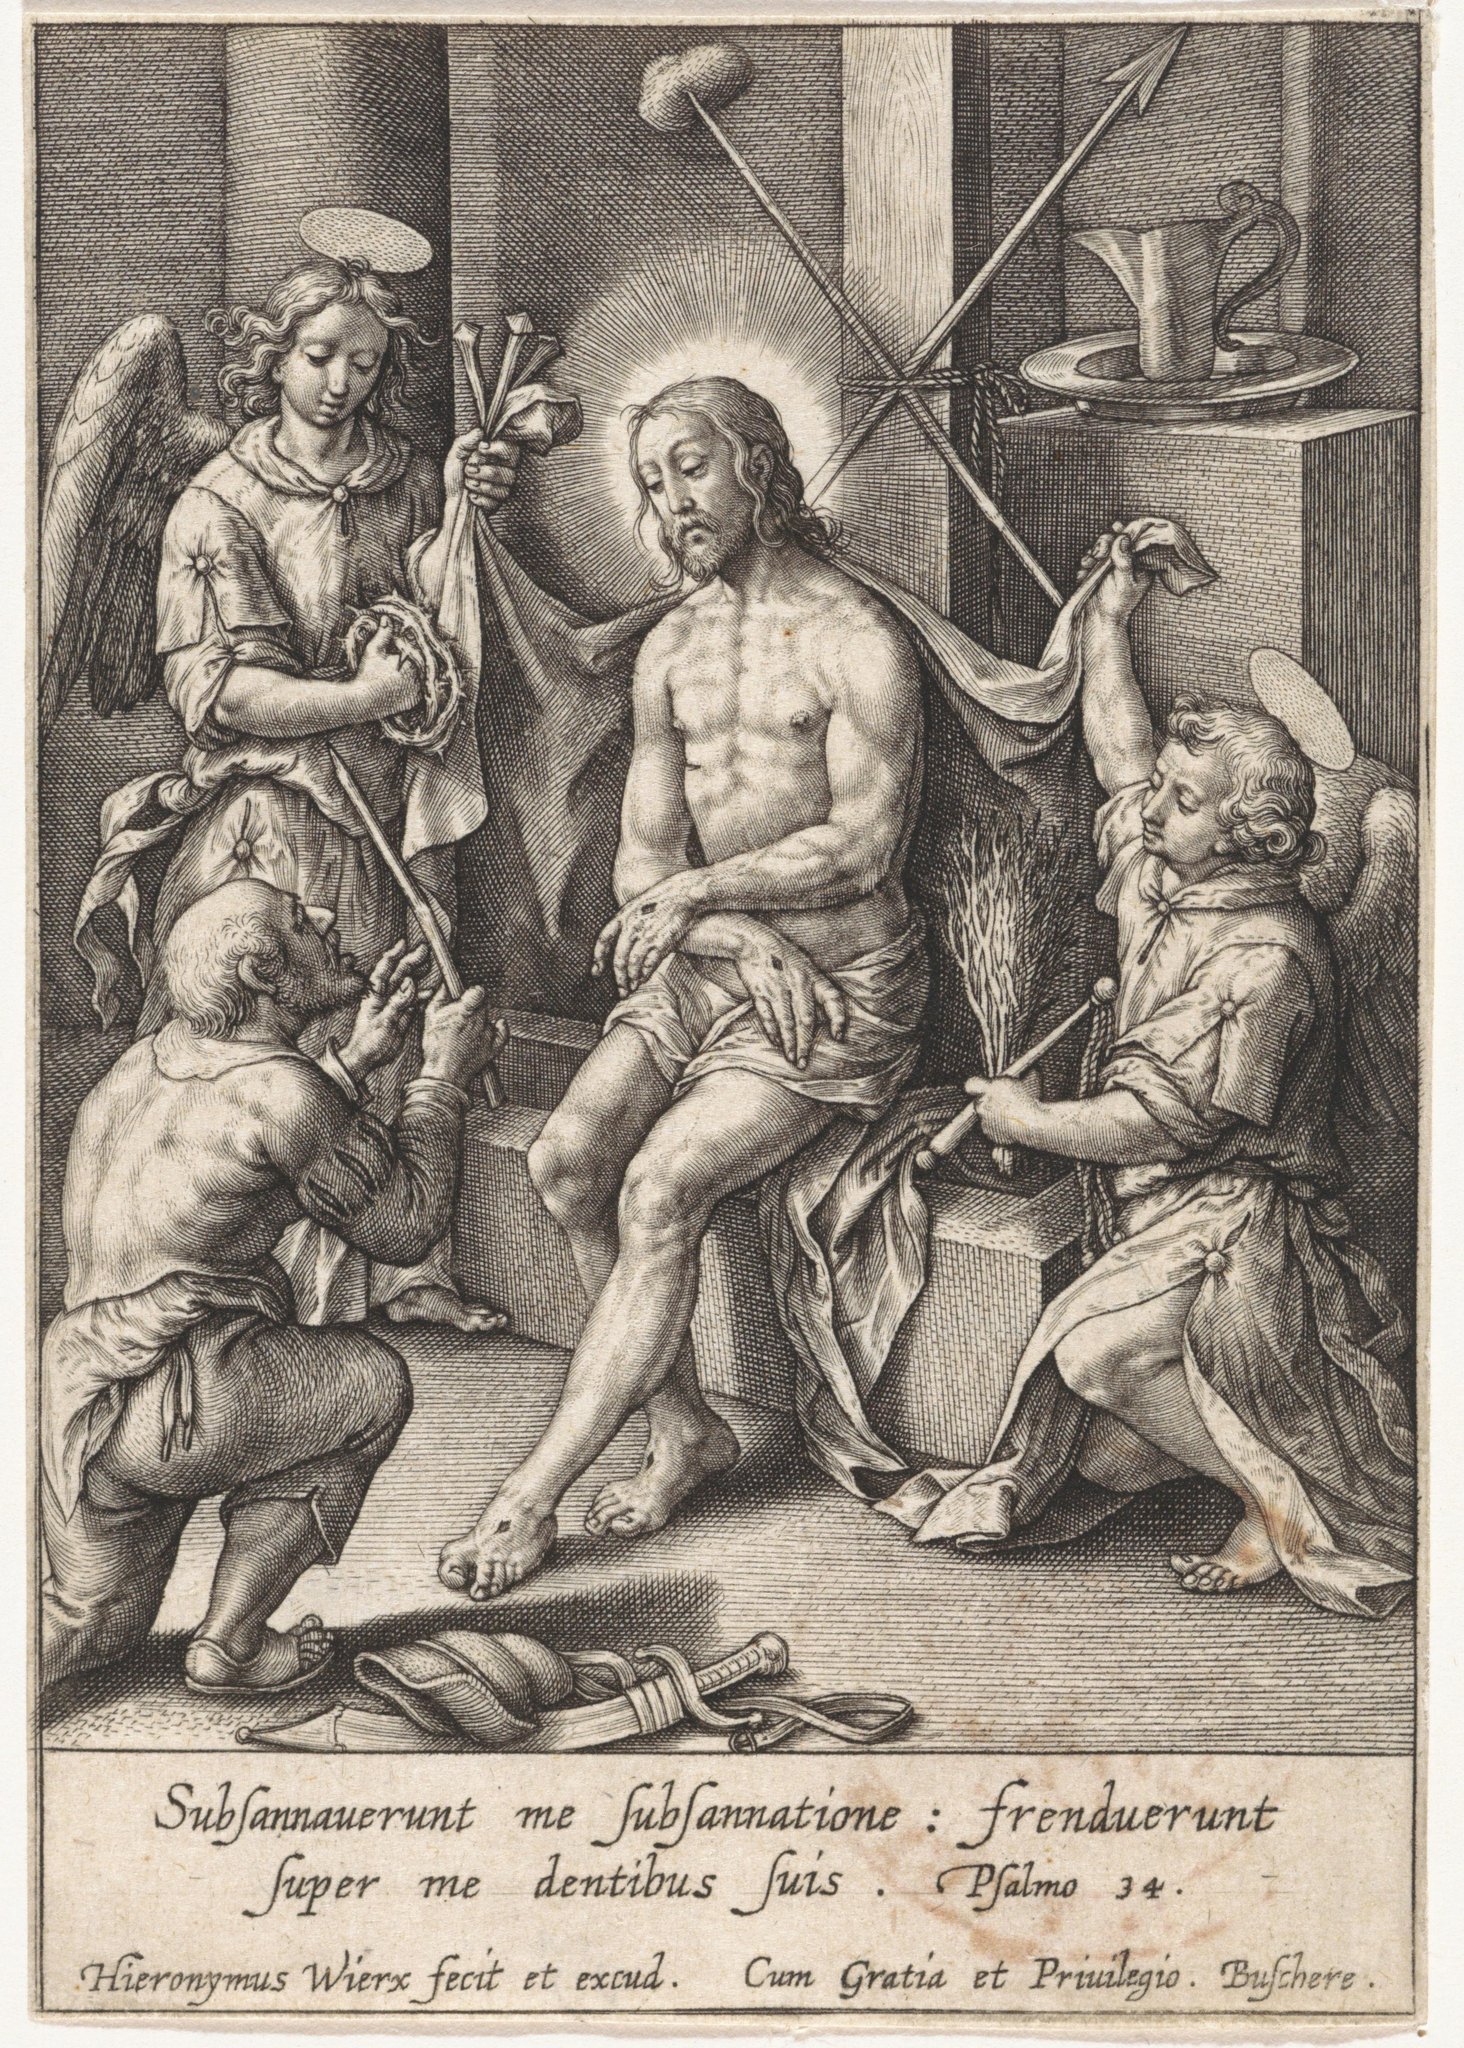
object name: print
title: Christus als man van smarten, vergezeld door engelen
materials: paper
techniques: engraving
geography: antwerp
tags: reed ~ instruments of the passion, man of sorrows, 'imago pietatis', 'erbärmdebild', 'schmerzensmann'; the upright christ showing his wounds, usually bearing the crown of thorns, and accompanied by the instruments of the passion, standing or sitting in his tomb (+ angel(s))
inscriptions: collector's mark: Lugt 240, number: ‘59’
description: Christus zit aan de voet van het kruis en toont zijn wonden. Aan weerszijden van hem engelen met de passiewerktuigen. Een geknielde man overhandigt de rietstengel aan Christus. In de marge een tweeregelig Bijbelcitaat uit Ps. 34 in het Latijn.